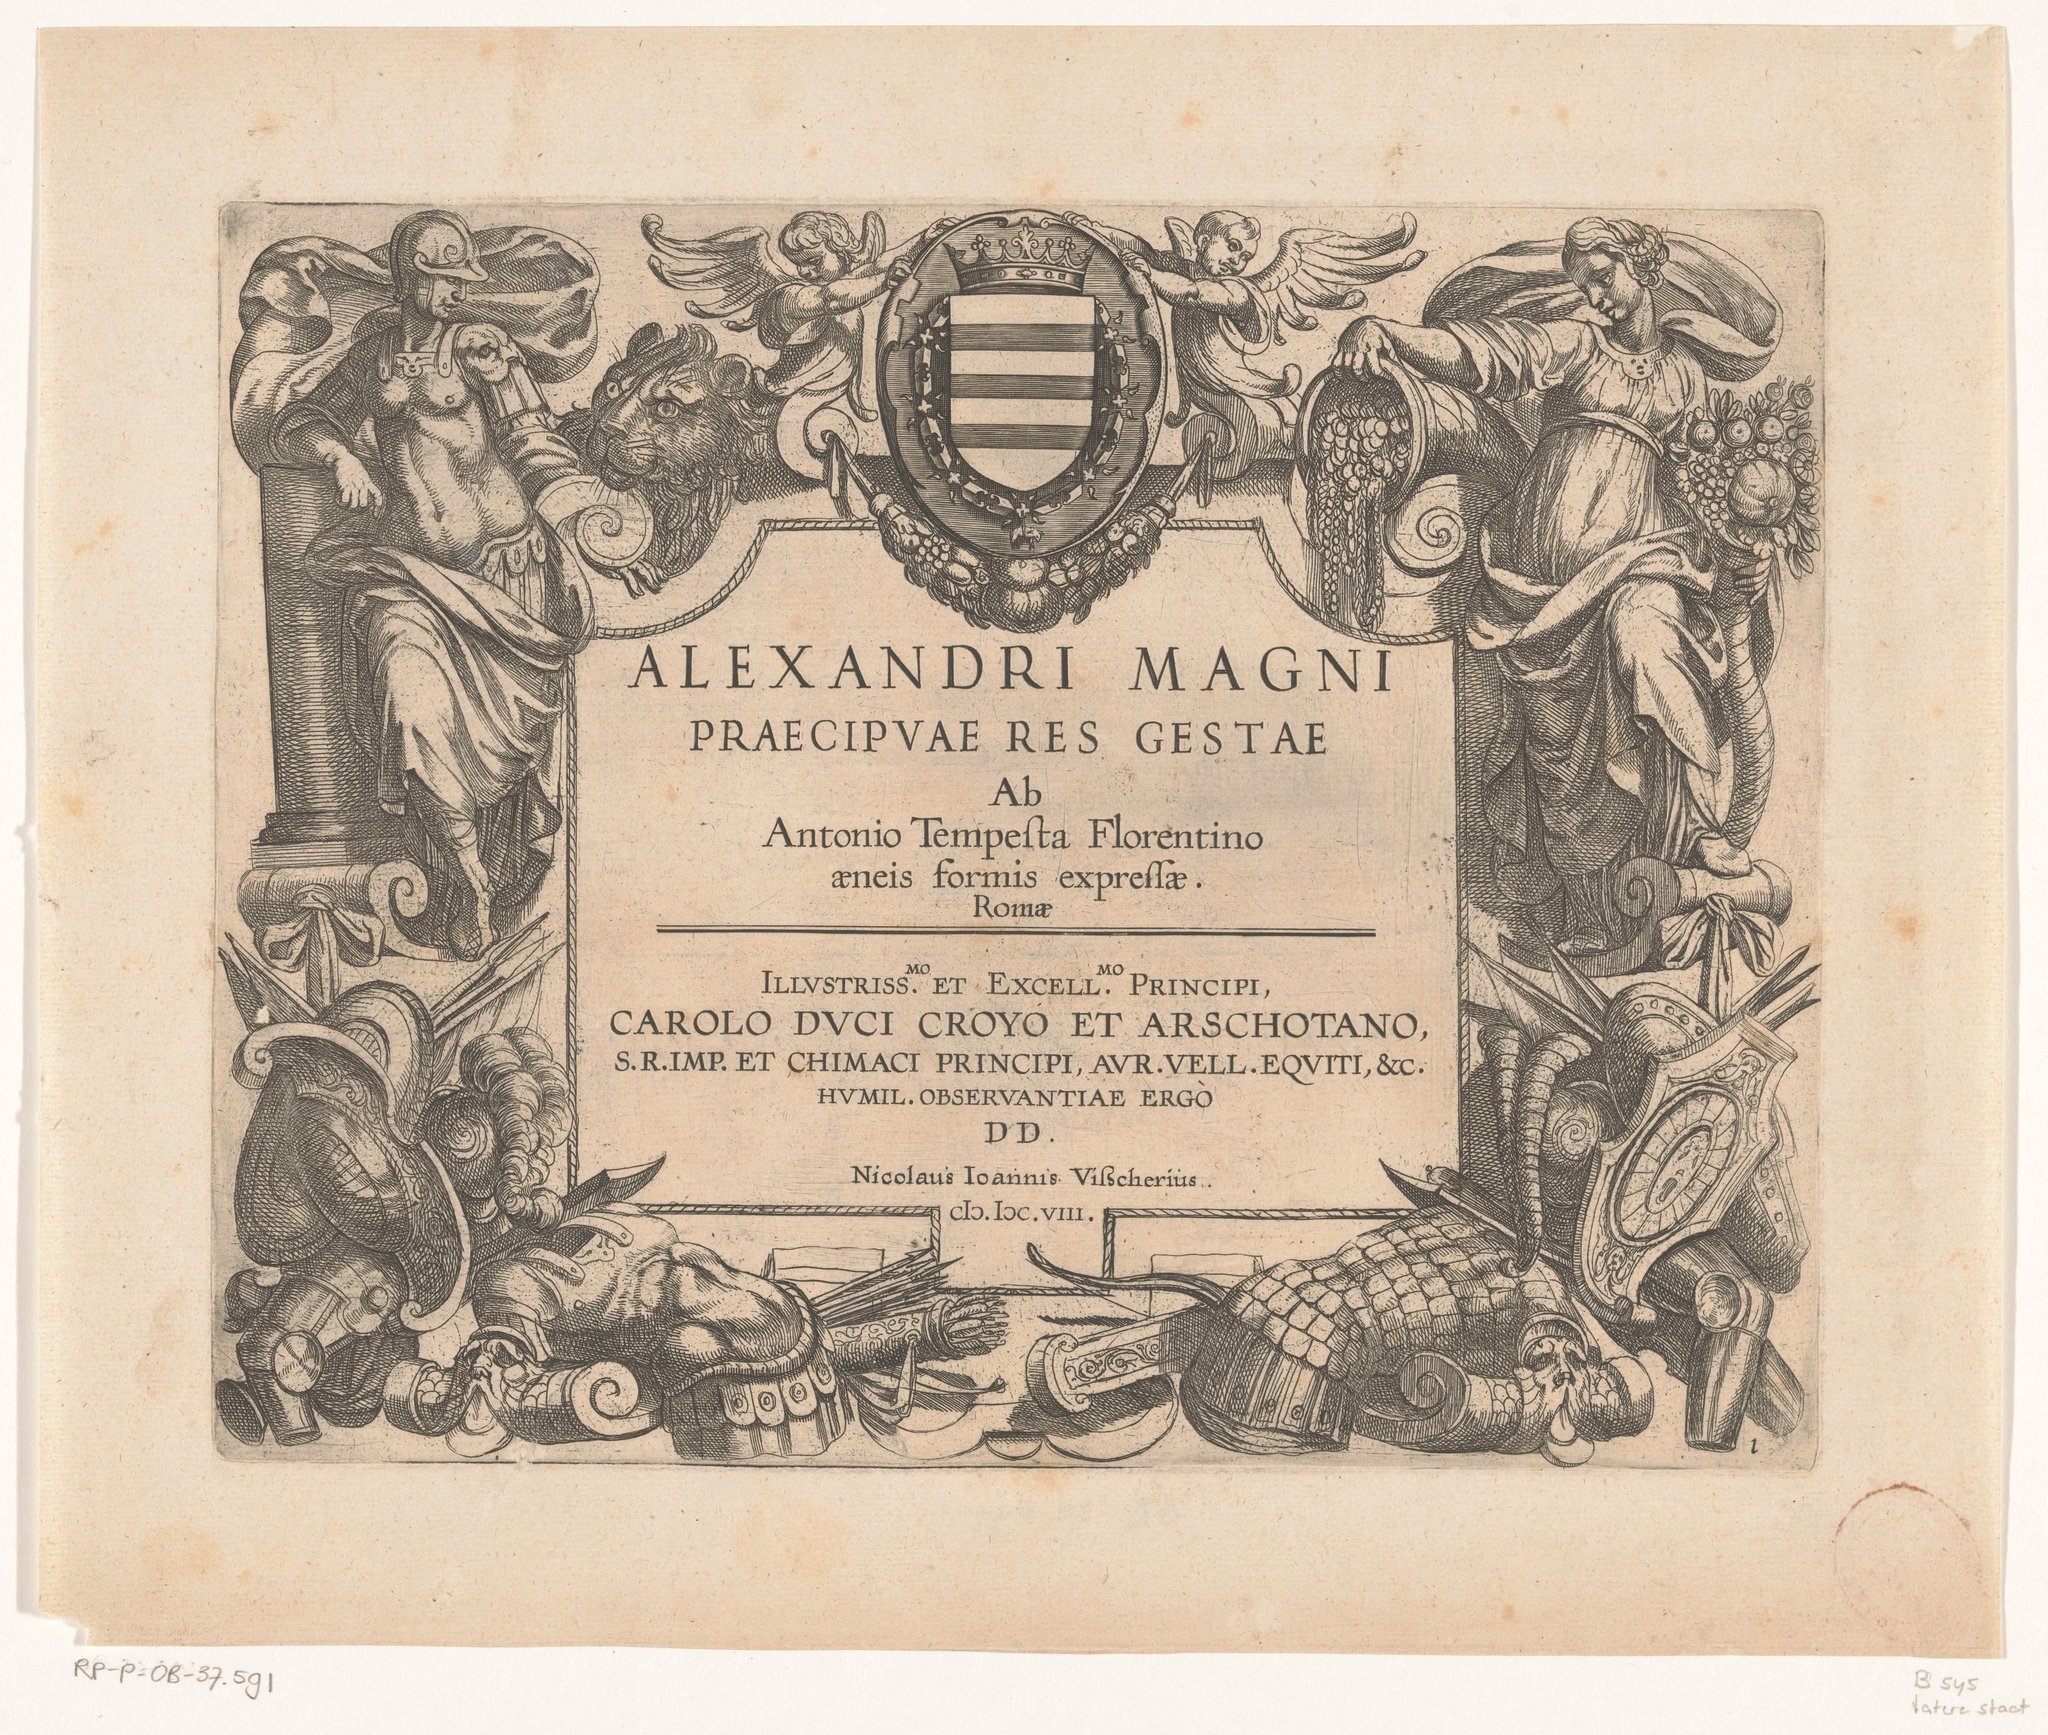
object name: titelprent, frontispice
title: Alexandri magni praecipvae res gestae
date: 1596-1652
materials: paper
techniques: etching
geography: amsterdam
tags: fortitude, 'fortitudo' ~ one of the four cardinal virtues, coat of arms (as symbol of the state, etc.), armour, weapons, cupids: 'amores', 'amoretti', 'putti'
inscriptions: collector's mark: Lugt 240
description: Cartouche met personificaties van Standvastigheid leunend op een zuil en Veelvuldigheid met hoornen des overvloeds. Middenboven flankeren twee putti een gekroond wapenschild. Aan de onderzijde wapentuig en harnassen.